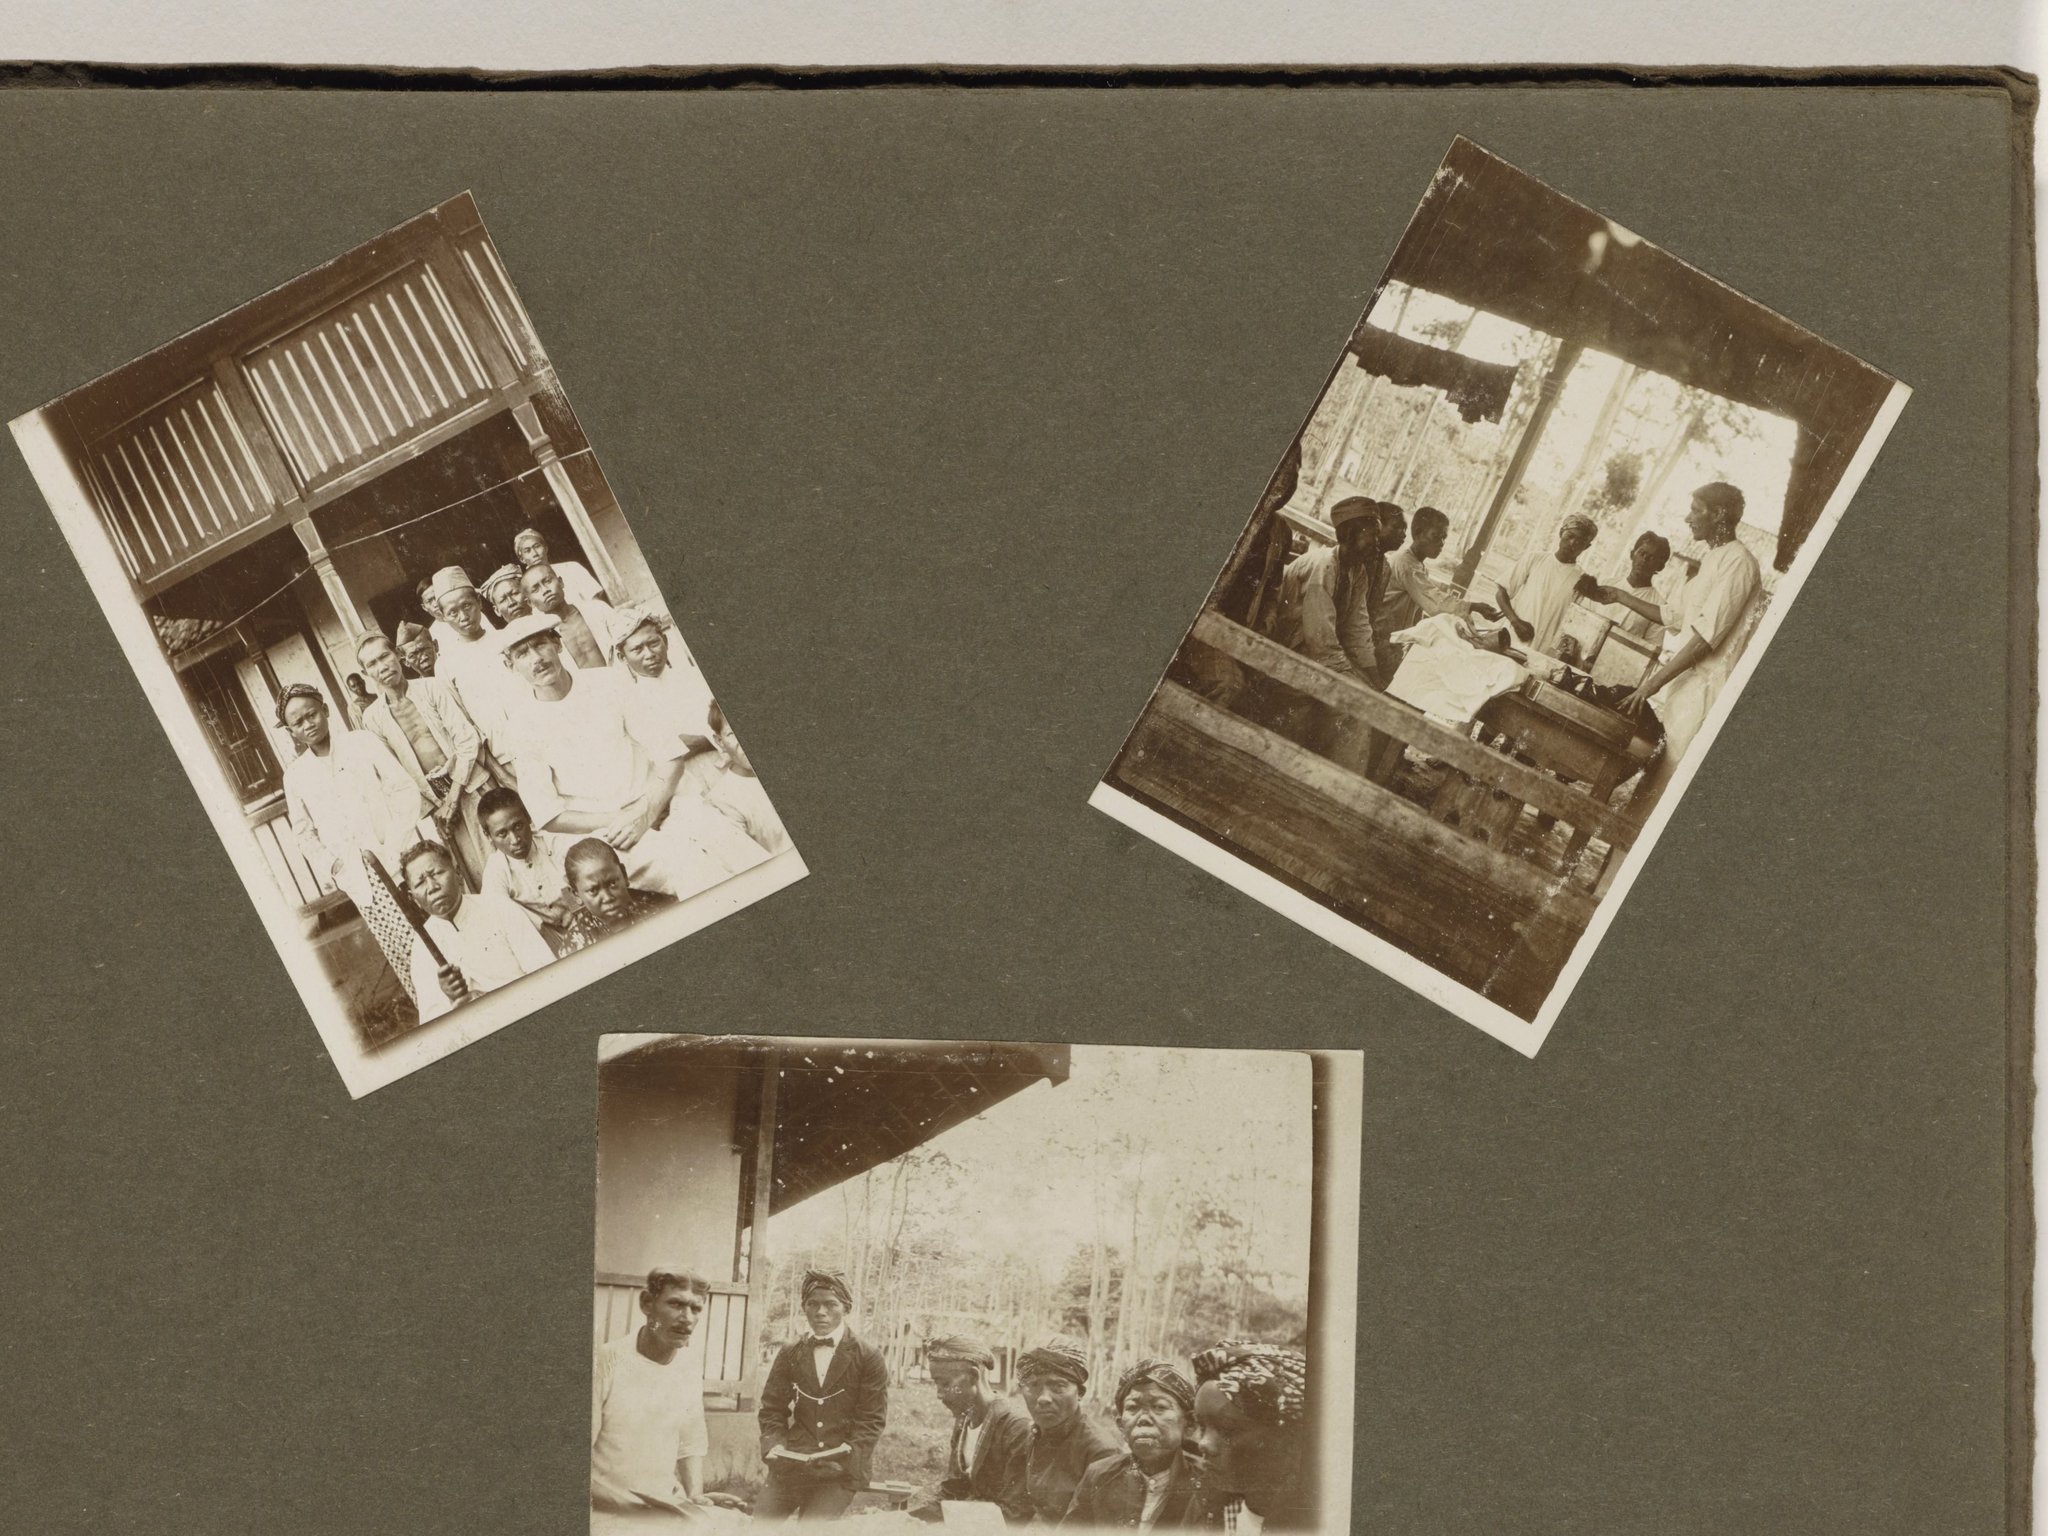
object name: album leaf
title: Leprozenkolonie Danaradja: arts en personeel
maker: Anonymous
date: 1922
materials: cardboard, photographic support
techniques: daylight paper print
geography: kelet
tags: tap, faucet, physician, doctor, patient, sick person, leprosy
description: Albumblad met drie foto's van leprozenkolonie Danaradja: vermoedelijk een arts temidden van Indische personeel. Mogelijk betreft het hier dokter C. Gramberg, werkzaam in de kolonie. Onderdeel van Fotoalbum leprozenkolonie Danaradja en familieopnames.